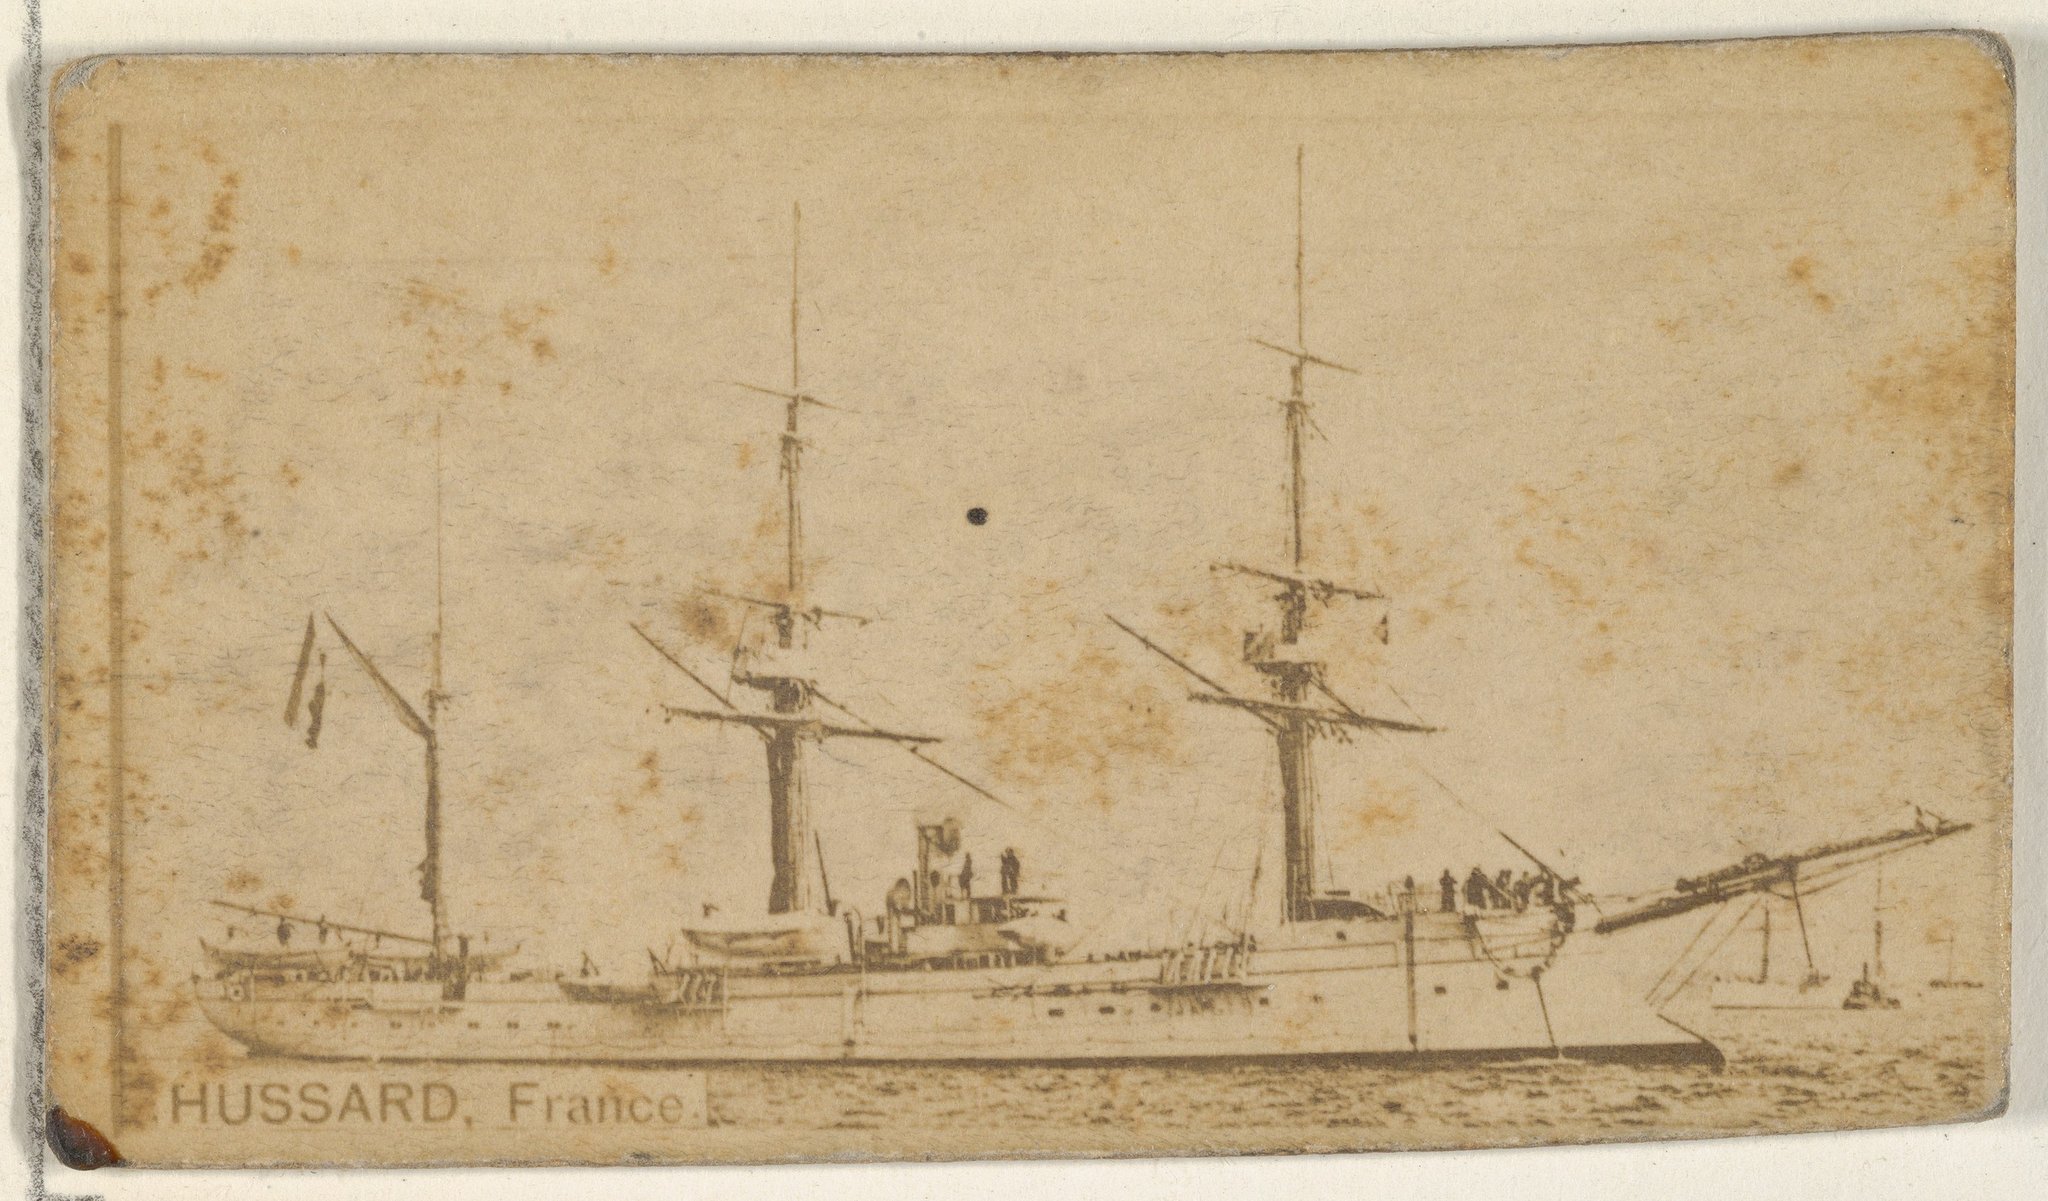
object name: photograph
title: Hussard, France, from the Famous Ships series (N50) for Virginia Brights Cigarettes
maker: allen & ginter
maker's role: publisher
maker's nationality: american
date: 1895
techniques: albumen silver print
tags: ships